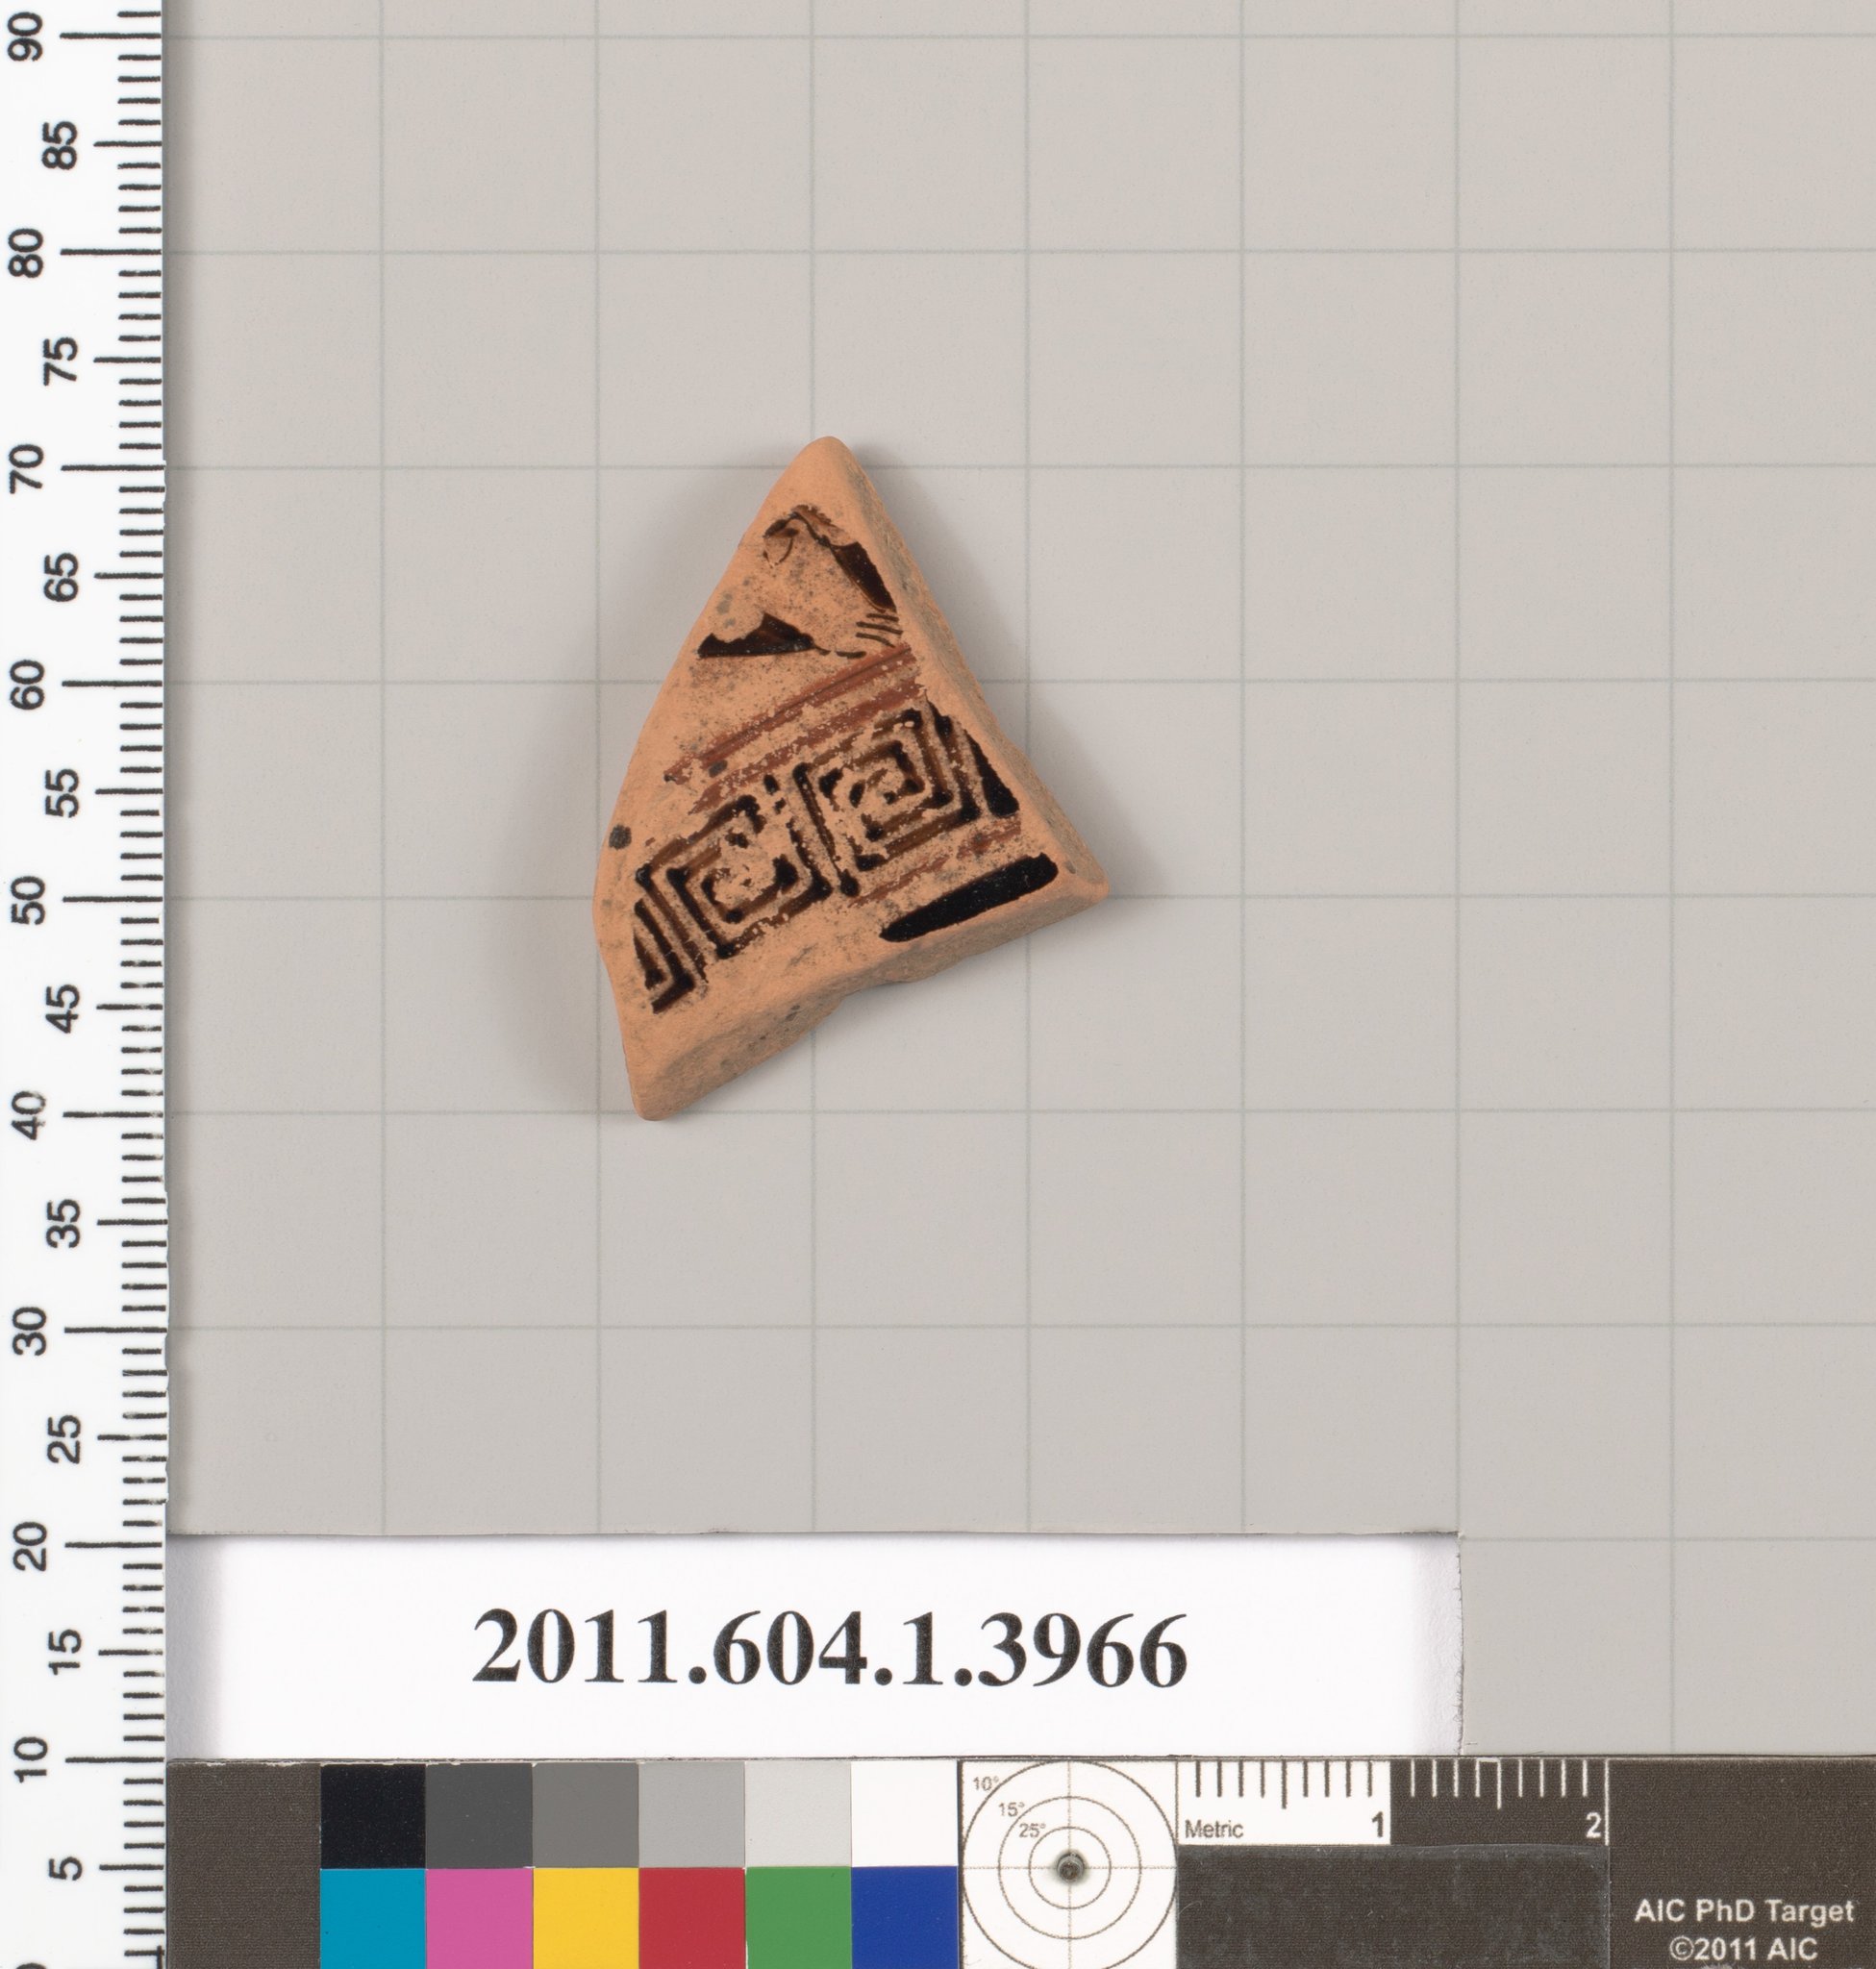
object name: kylix fragment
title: Terracotta fragment of a kylix (drinking cup)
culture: greek, attic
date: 490-470 BCE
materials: terracotta